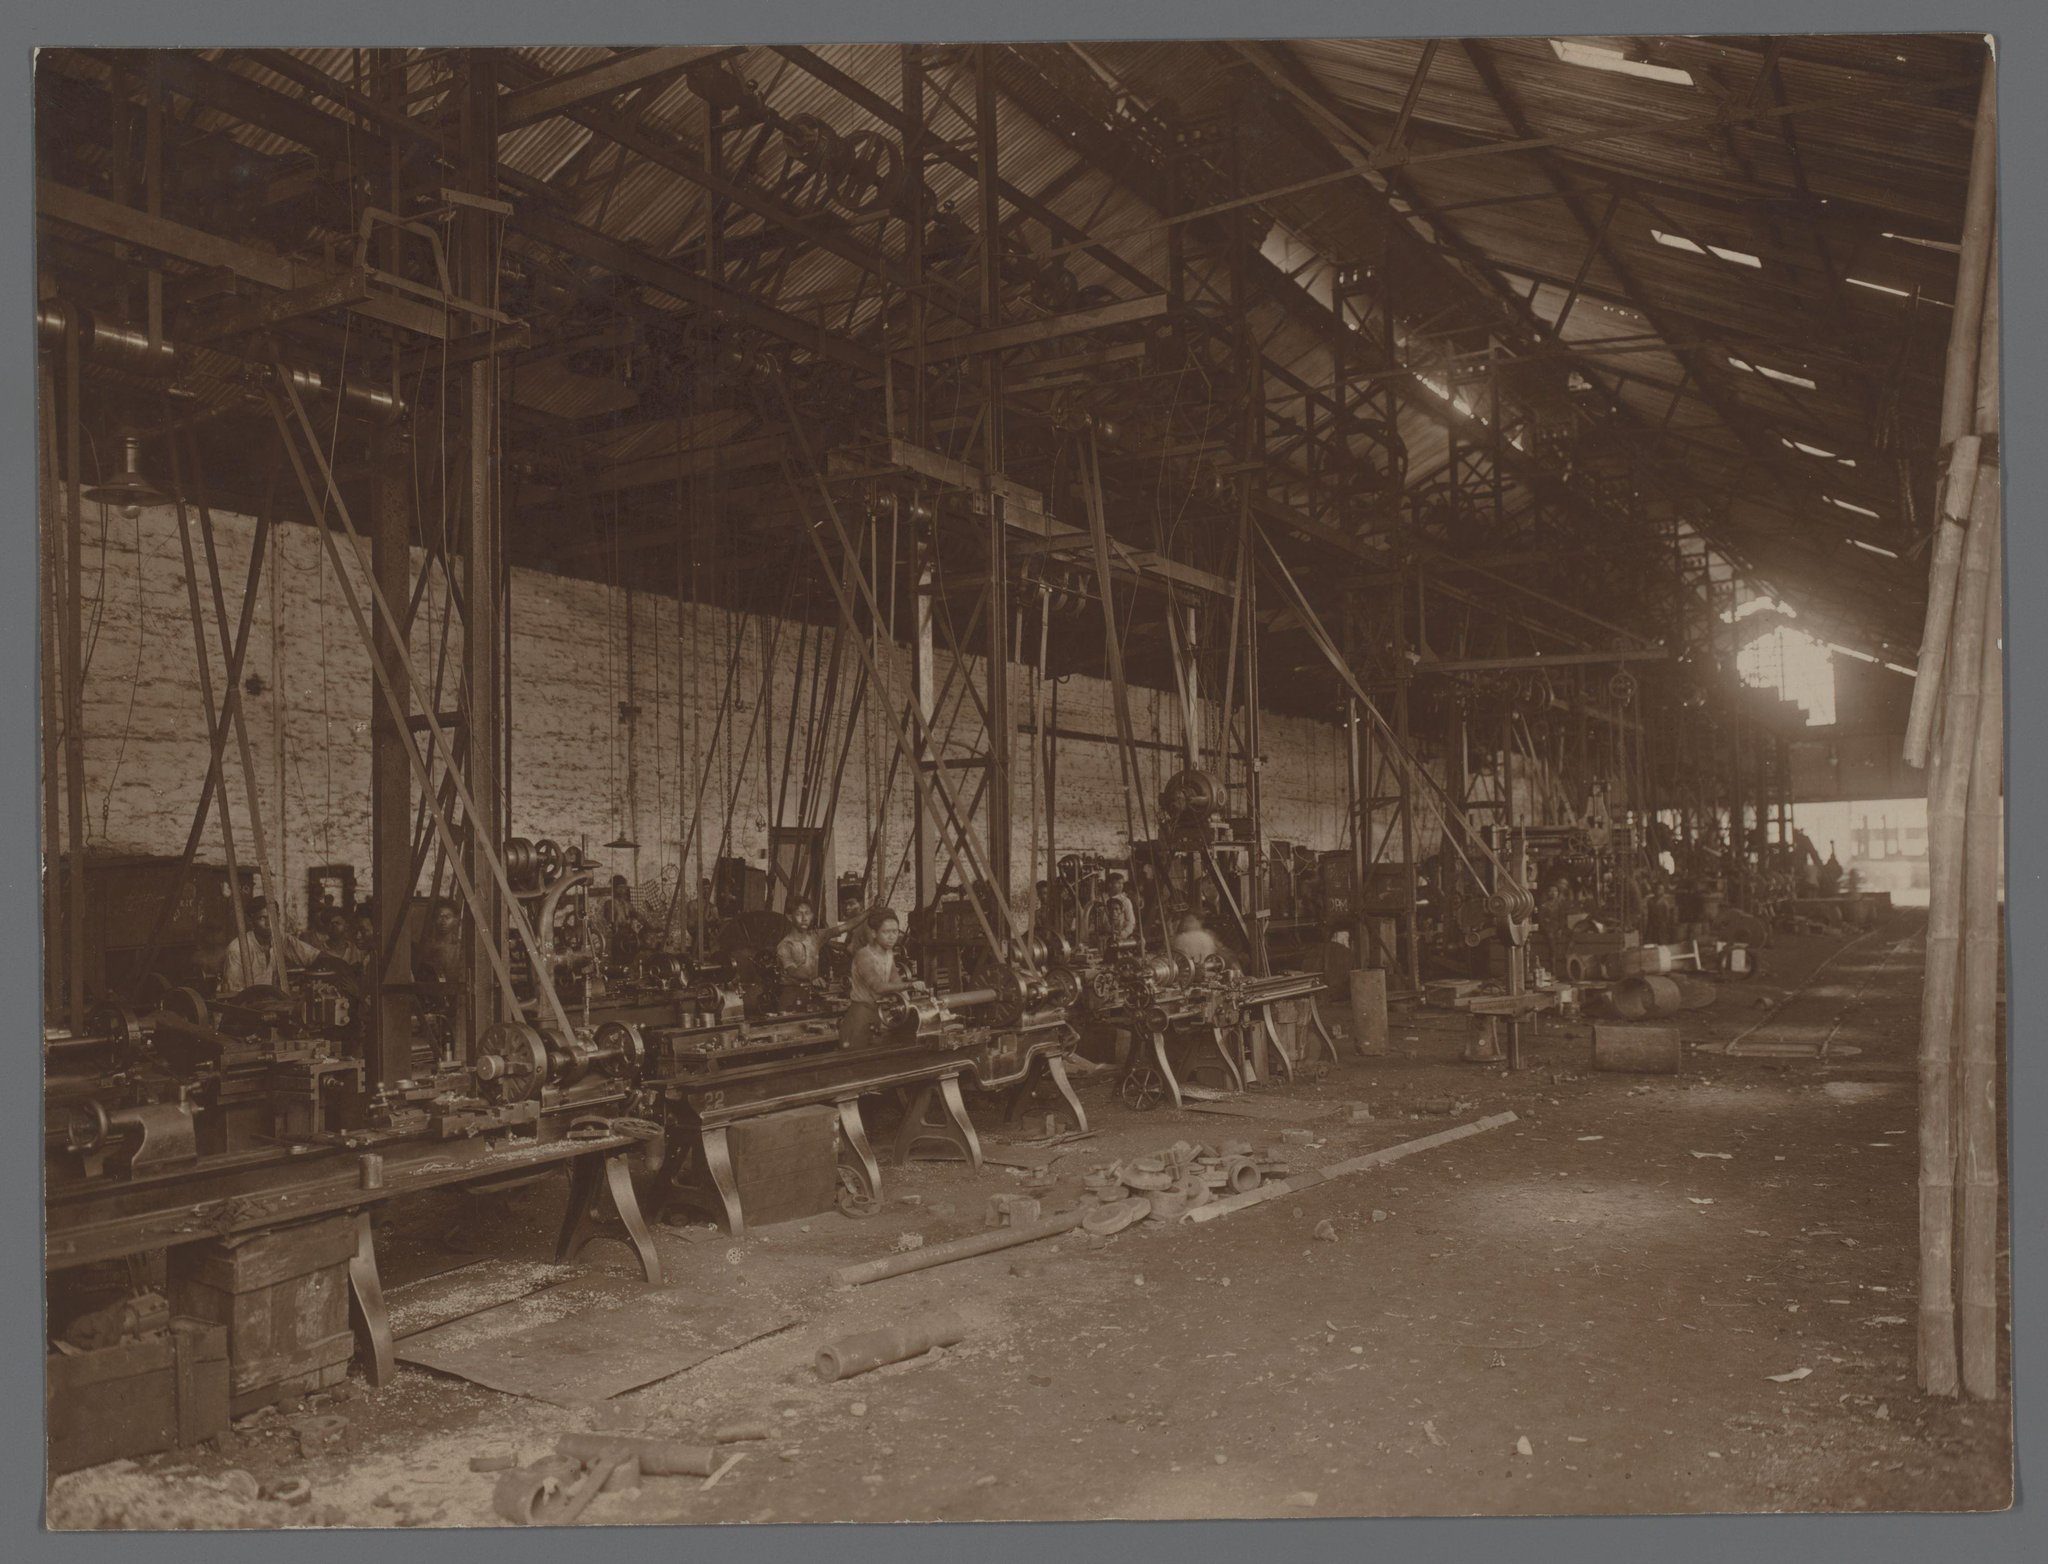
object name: photograph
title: Eerste draaierij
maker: Anonymous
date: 1908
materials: photographic support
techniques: photography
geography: surabaya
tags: colonial system, factory-interior, machine shop, machines; parts of machines; tools and appliances, java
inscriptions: date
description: Gezicht in de fabriekshal met de eerste draaierij geïnstalleerd in 1904. Hier in beeld na de electrificatie in 1908. Onderdeel van de multomap met foto's van machines van de N.V. Machinefabriek Braat te Soerabaja, Soekaboemi en Jogyakarta, uit de periode 1908-1942.